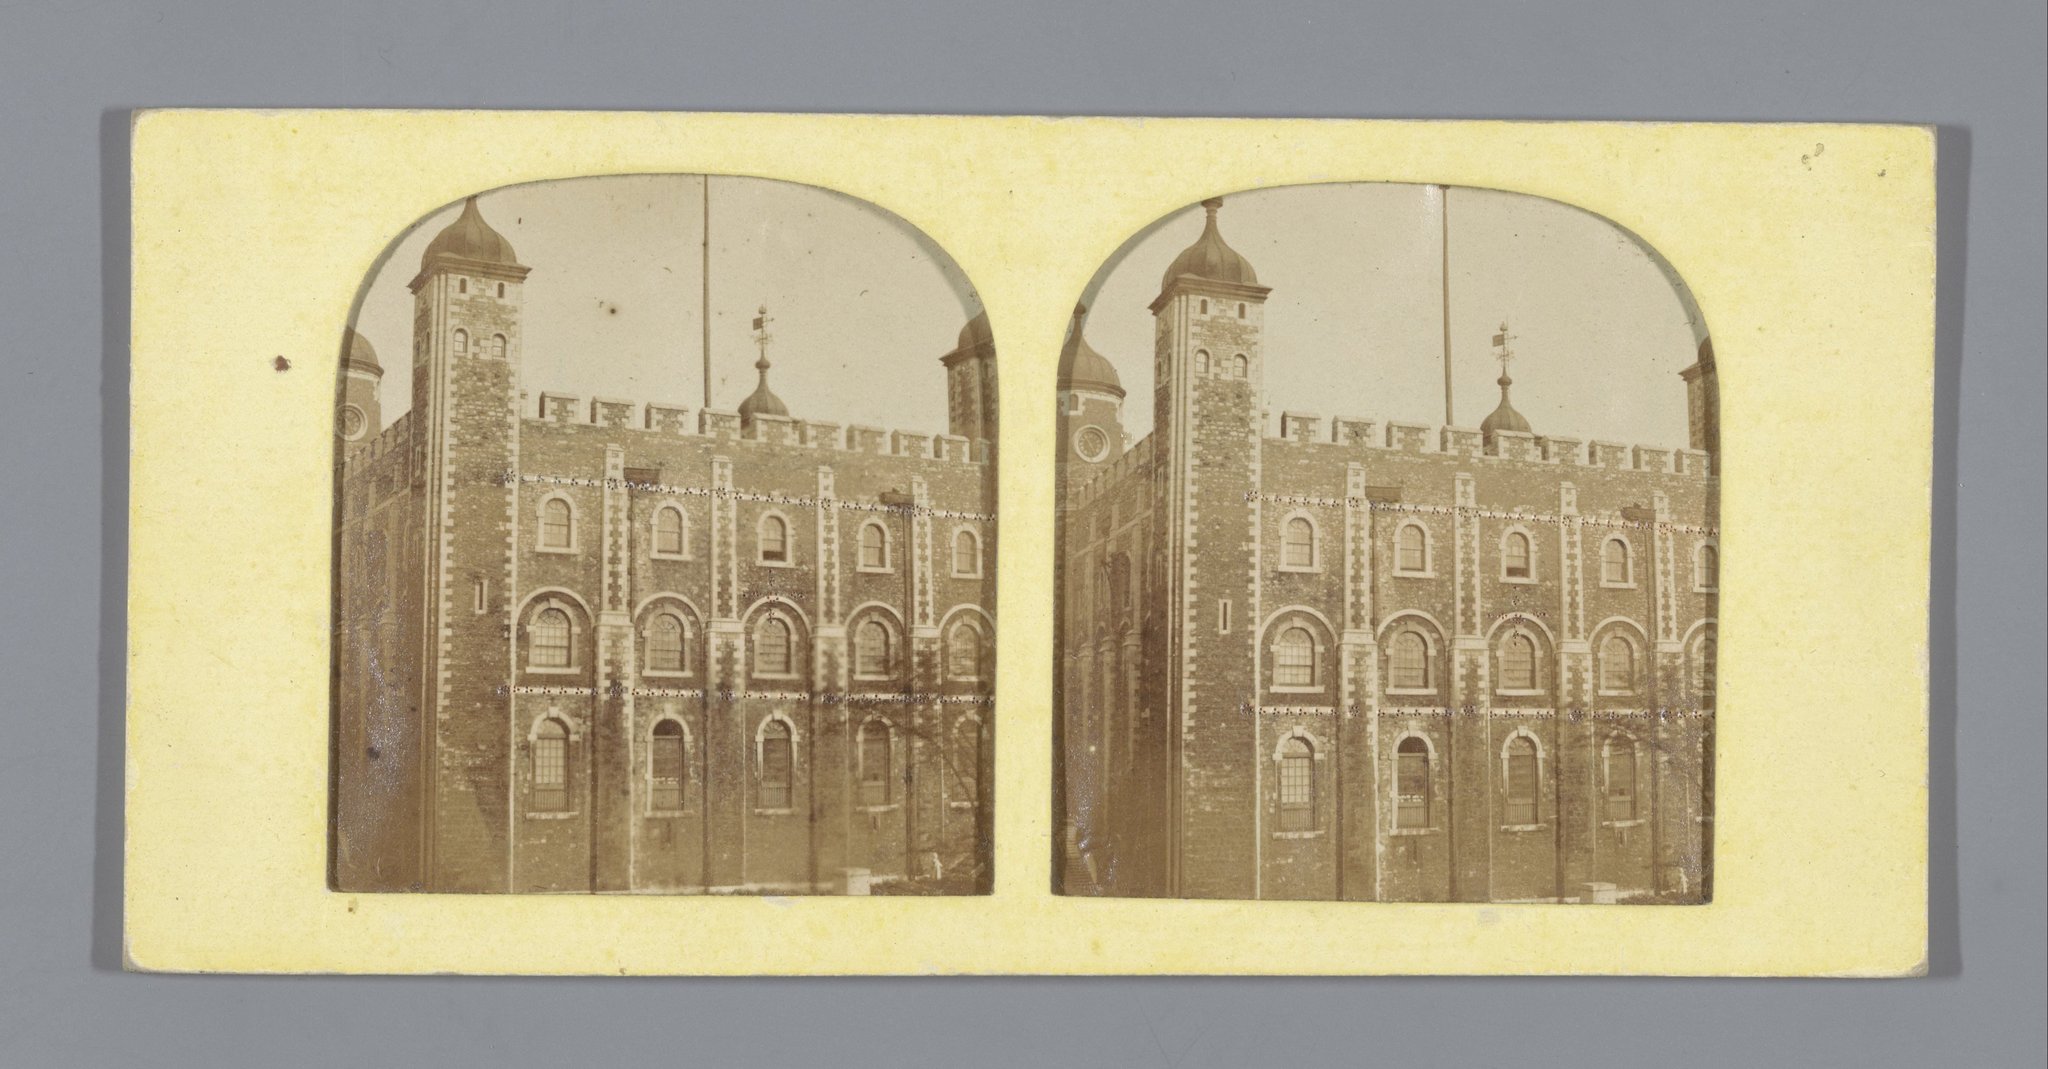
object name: tissue stereograph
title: London Illuminations at the Prince of Wales' Marriage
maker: Anonymous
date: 1855-1863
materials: cardboard, paper, photographic support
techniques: albumen print, hand coloring, perforating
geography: london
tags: castle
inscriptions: retailer's mark: ‘No. 6’, number: ‘No. 6’